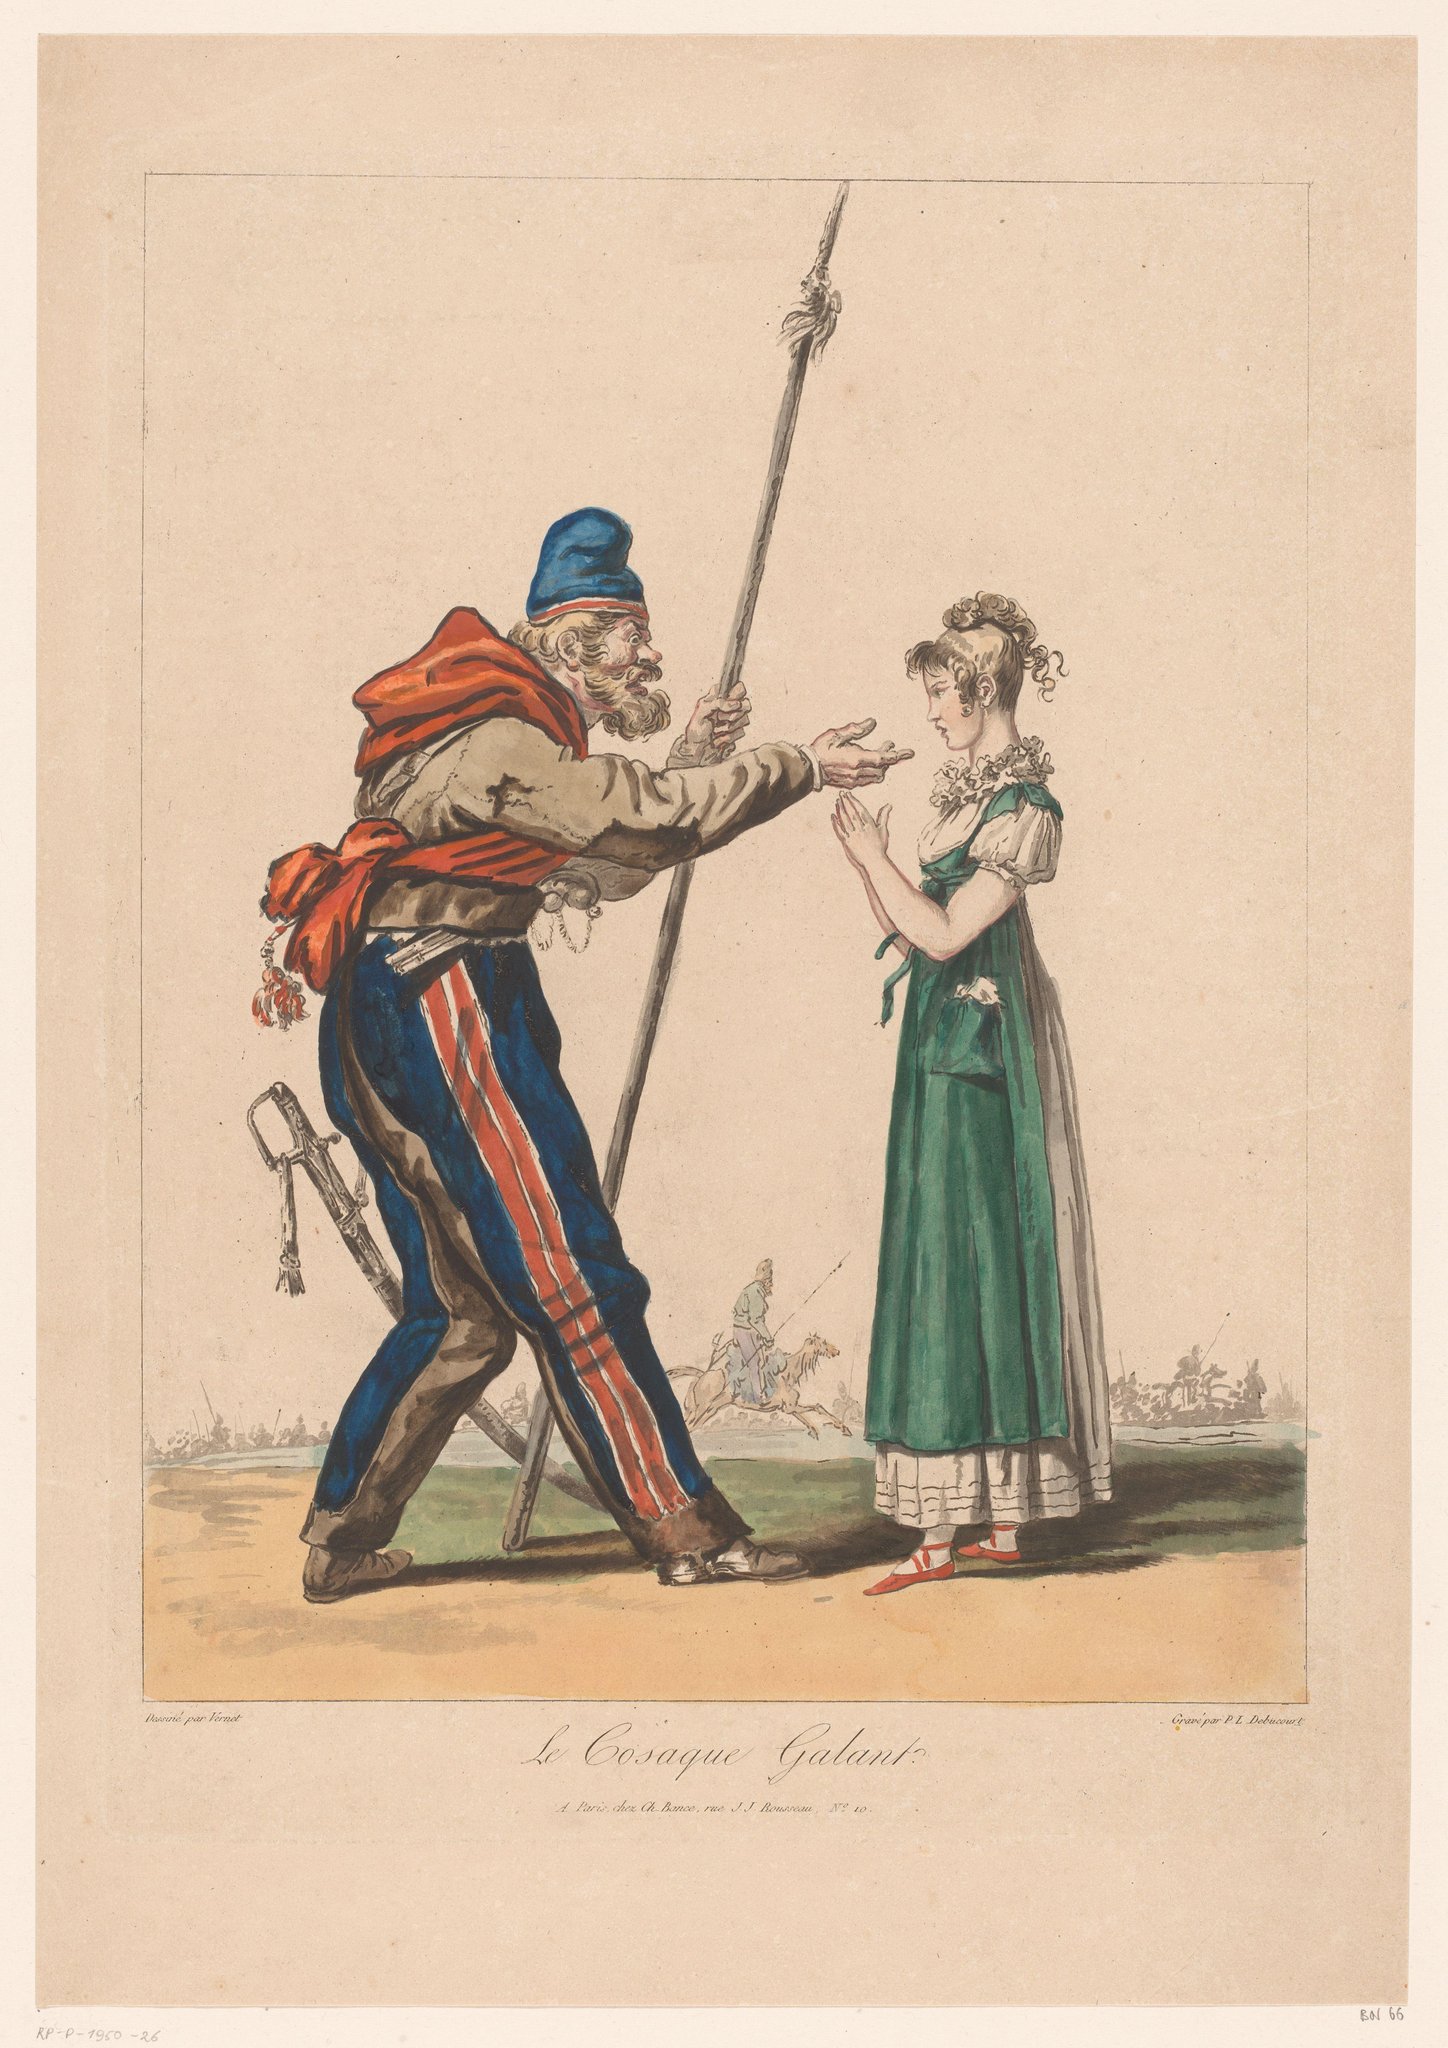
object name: print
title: Collection de costumes dessinés d'après nature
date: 1814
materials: paper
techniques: aquatint, hand coloring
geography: france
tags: woman-chaser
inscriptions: collector's mark: Lugt 2228